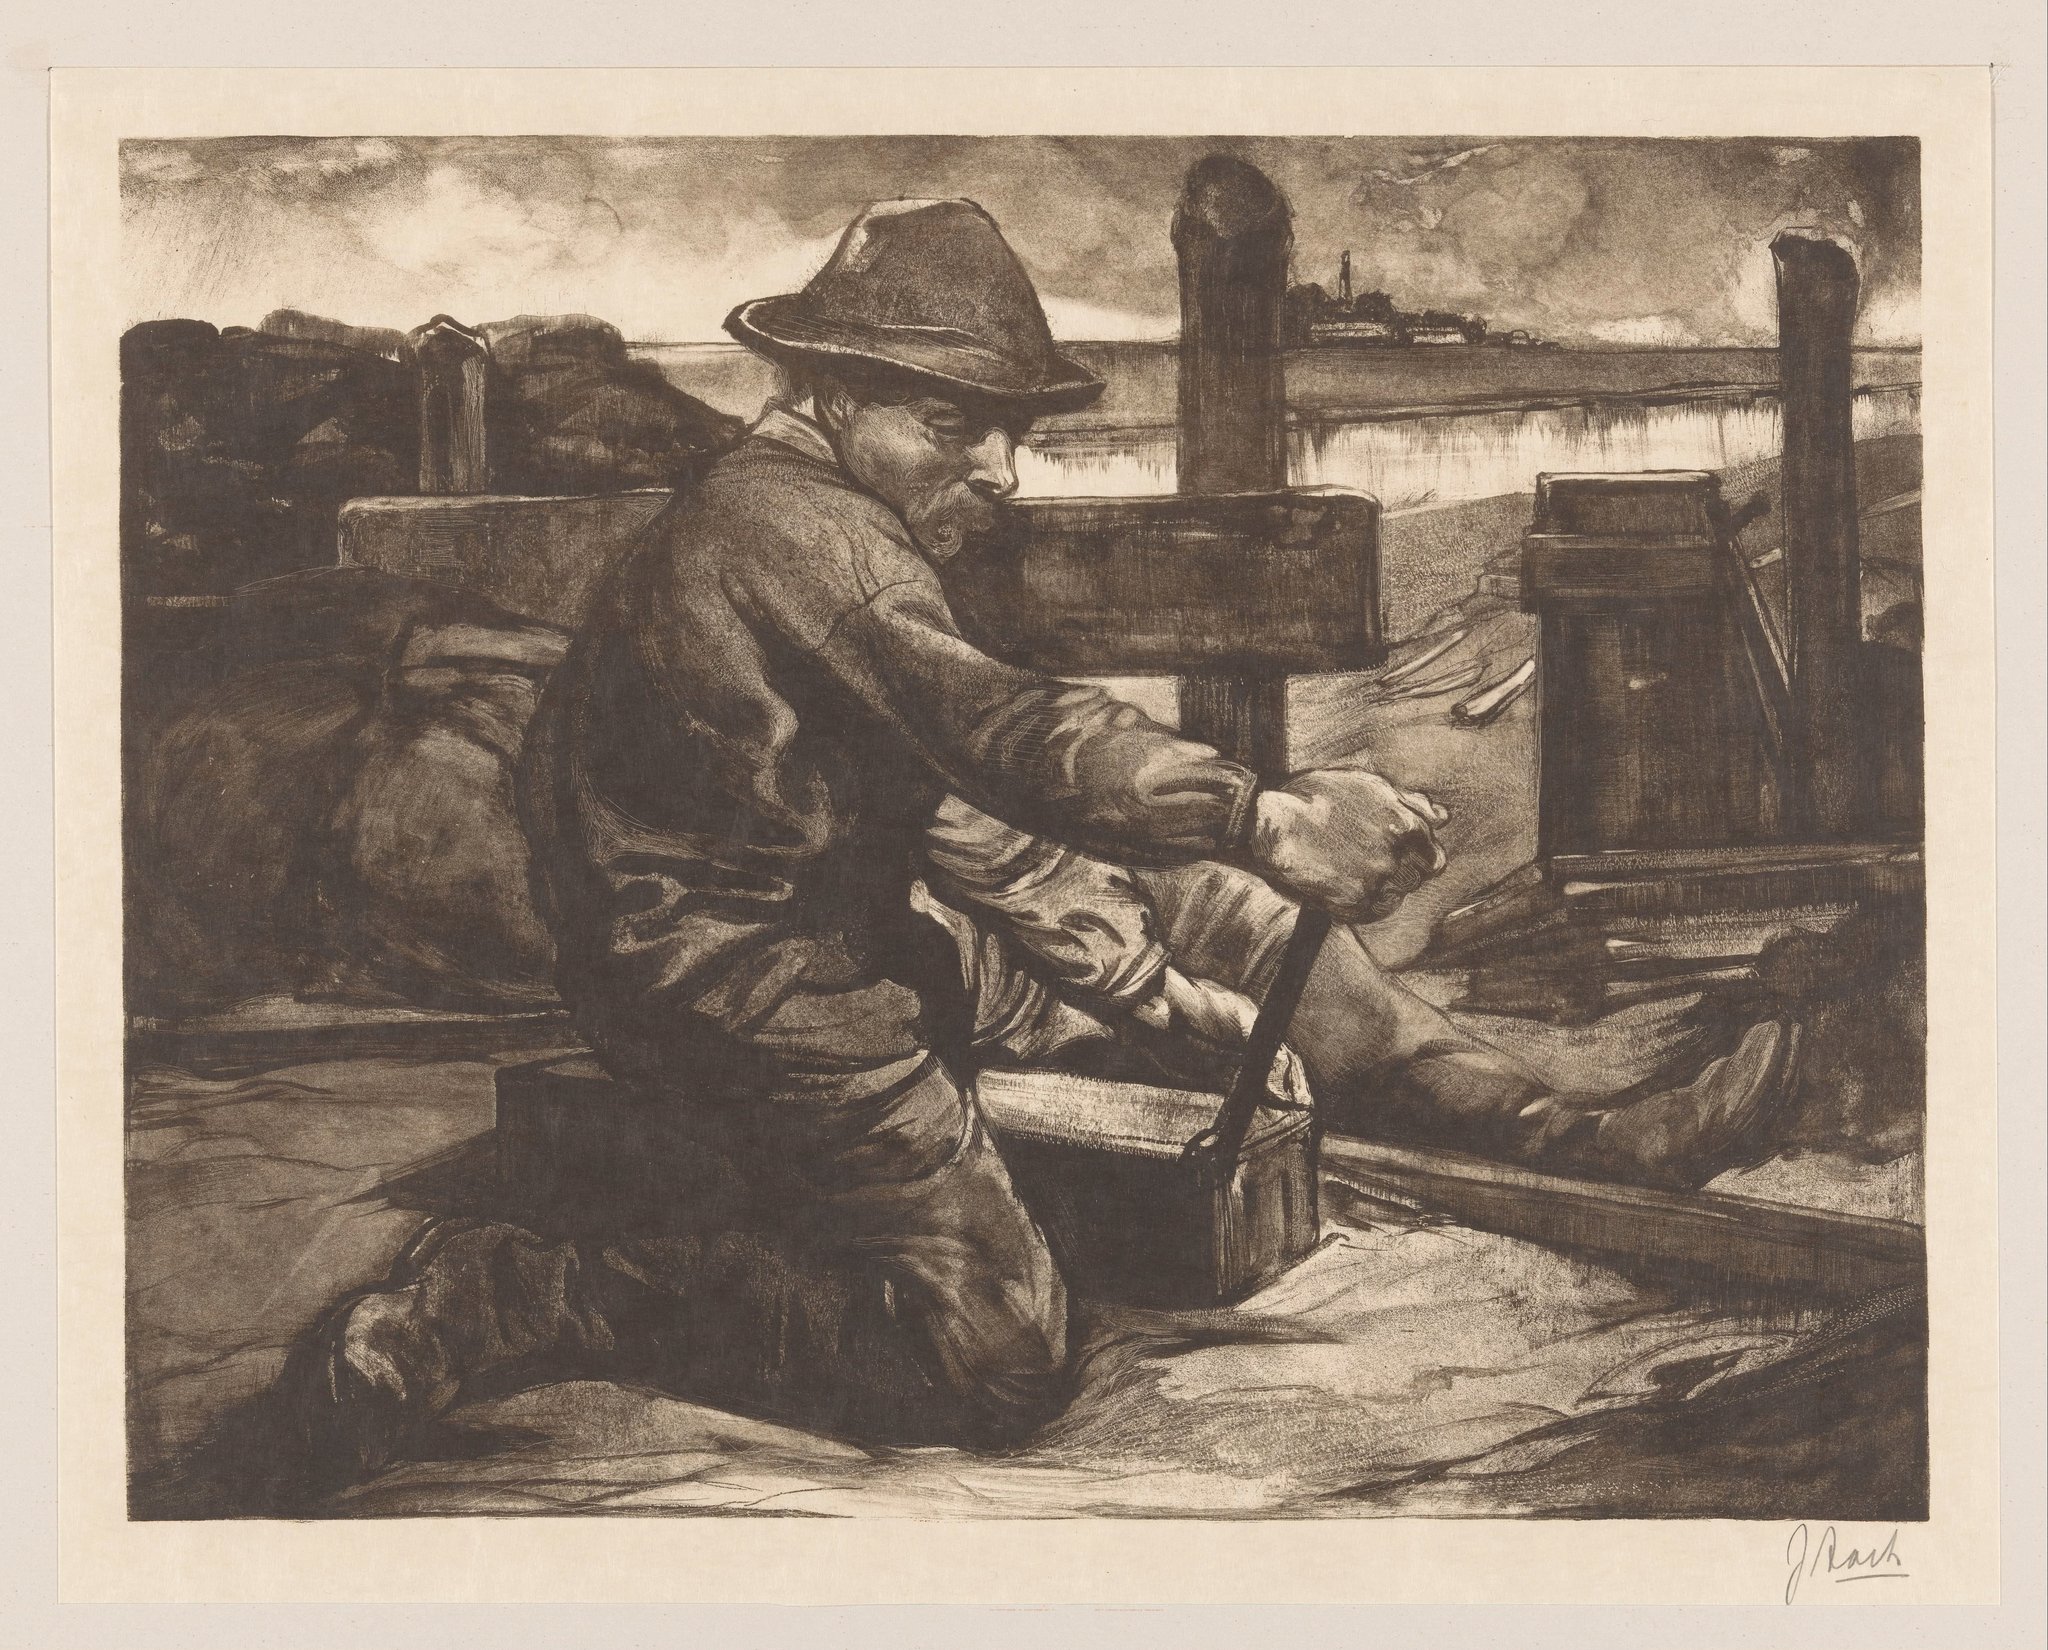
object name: print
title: Arbeider met steeksleutel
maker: johannes josephus aarts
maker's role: draughtsman, print maker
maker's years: 1871-1934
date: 1881-1931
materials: paper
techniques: lithograph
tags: tools, aids, implements ~ crafts and industries, working class, labourers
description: Een man in werkkleding draait met een steeksleutel aan een moer in de balk waar hij op zit. Achter hem een houten hek, een rivier, en aan de andere kant van de oever, een nederzetting met toren.